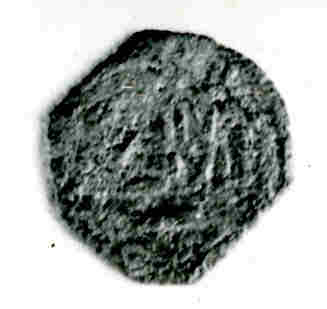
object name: coin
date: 701-900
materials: copper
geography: iran